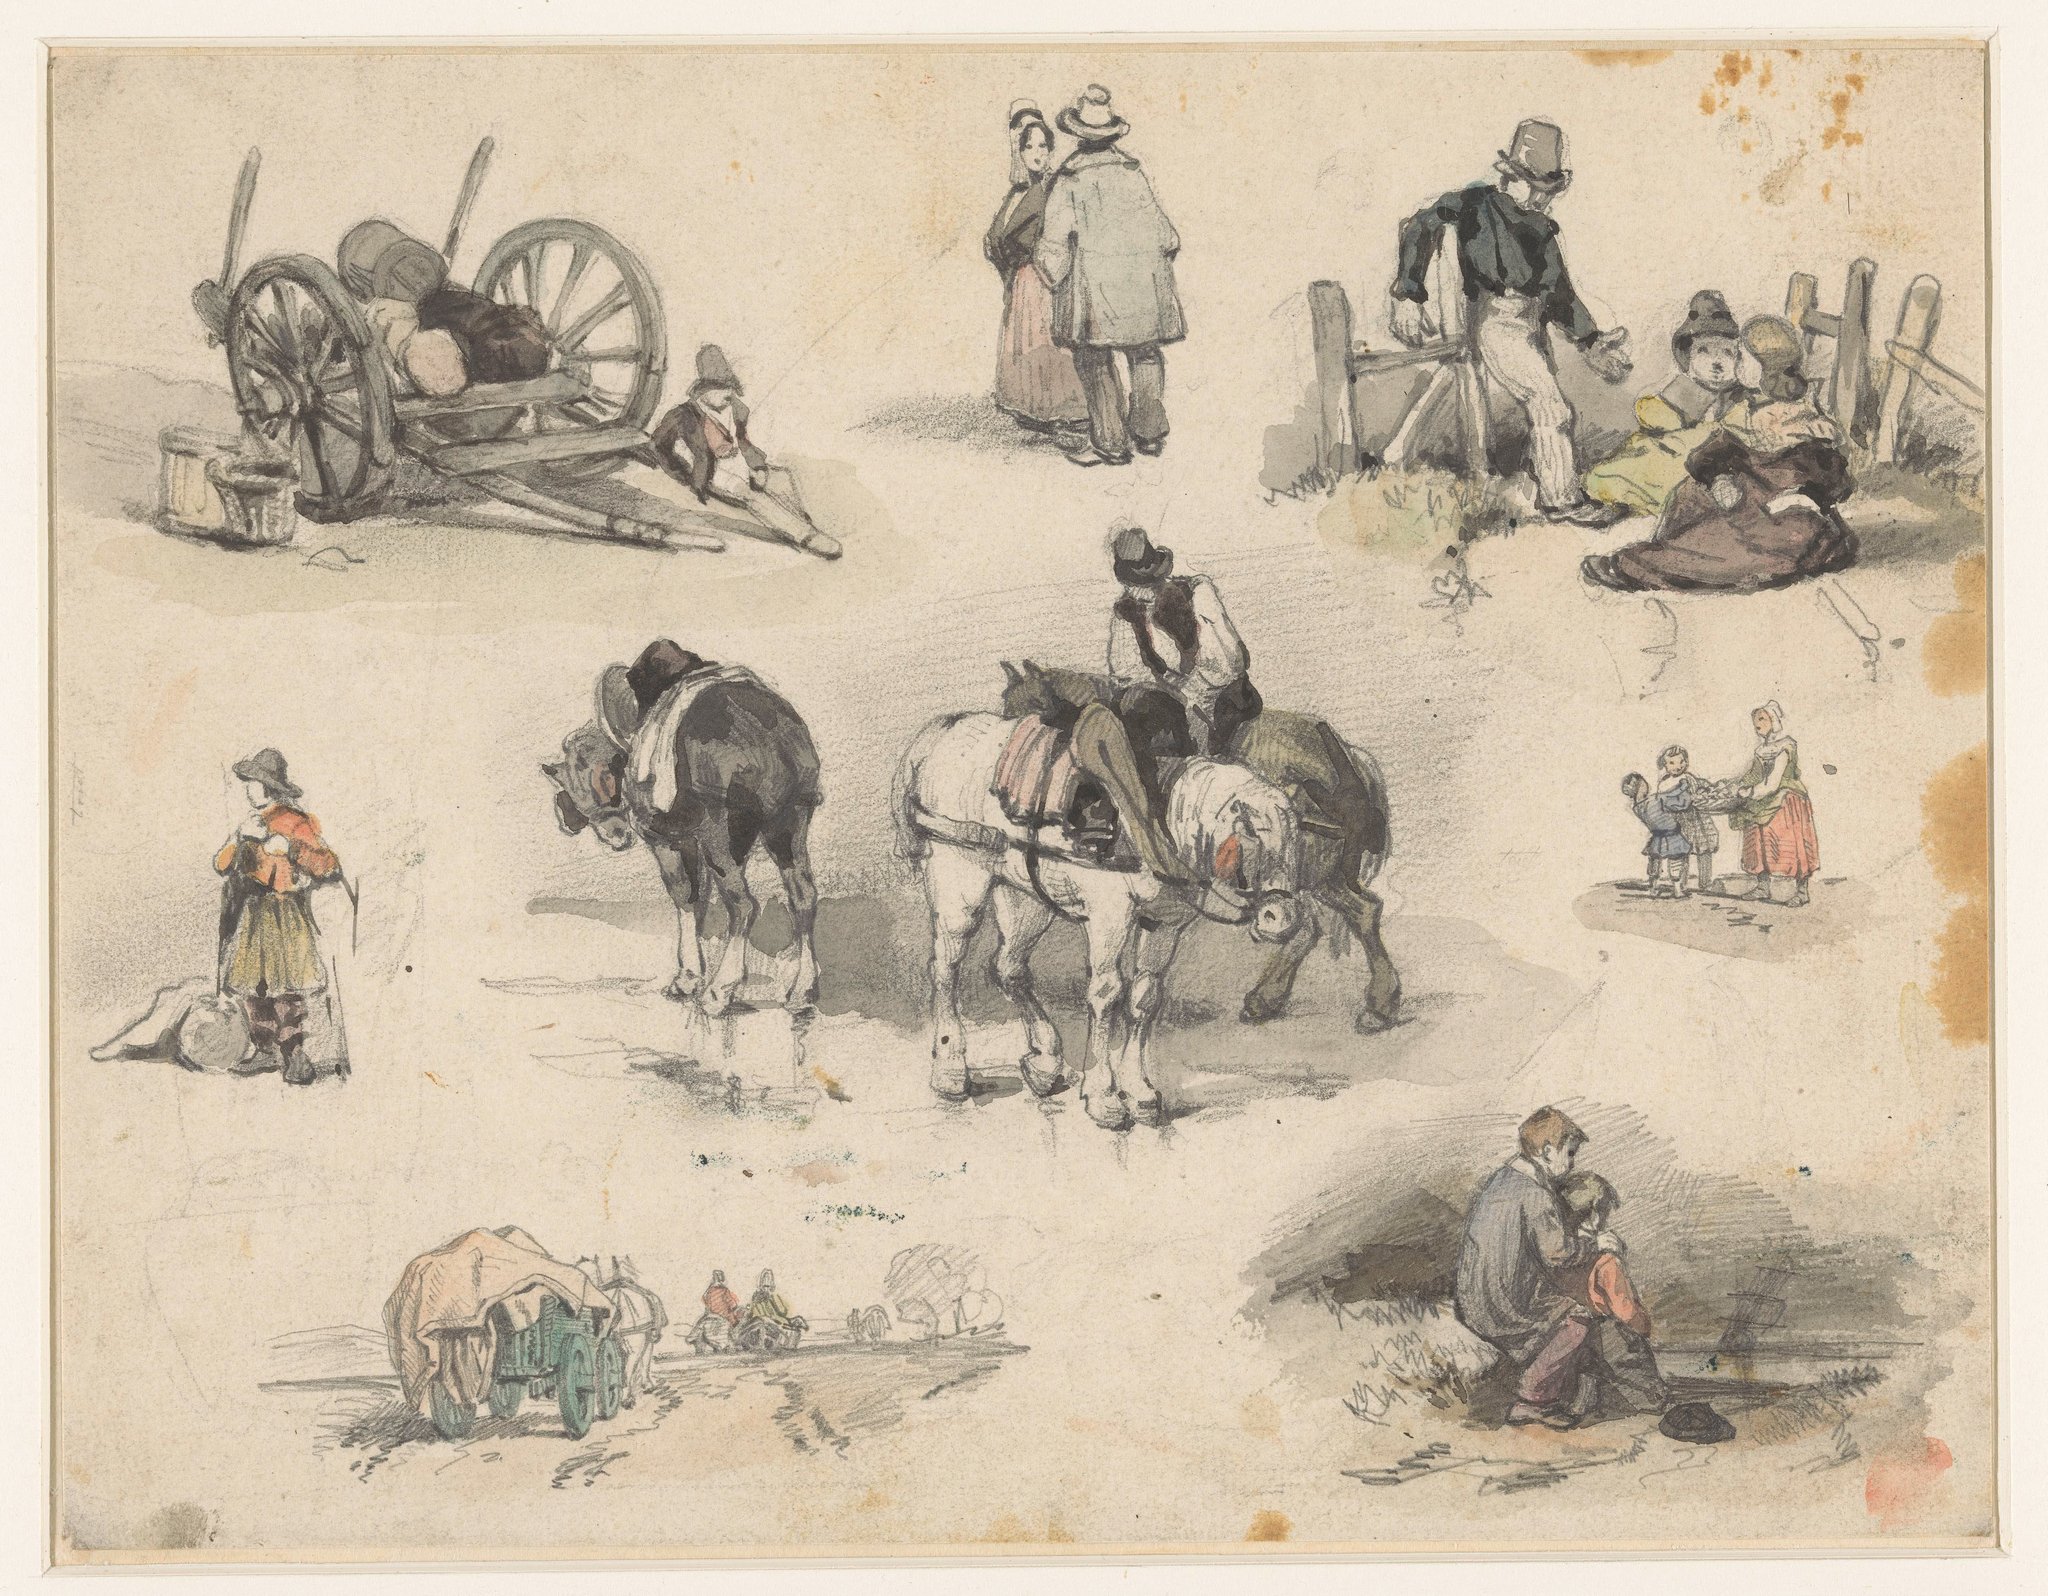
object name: drawing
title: Verschillende figuurstudies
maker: jan weissenbruch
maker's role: painter, print maker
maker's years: 1822-1880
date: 1832-1880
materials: paper, pencil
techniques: brush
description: figuurstudies naar 'Etudes progressives de figures pittoresques' van F. Férogio.